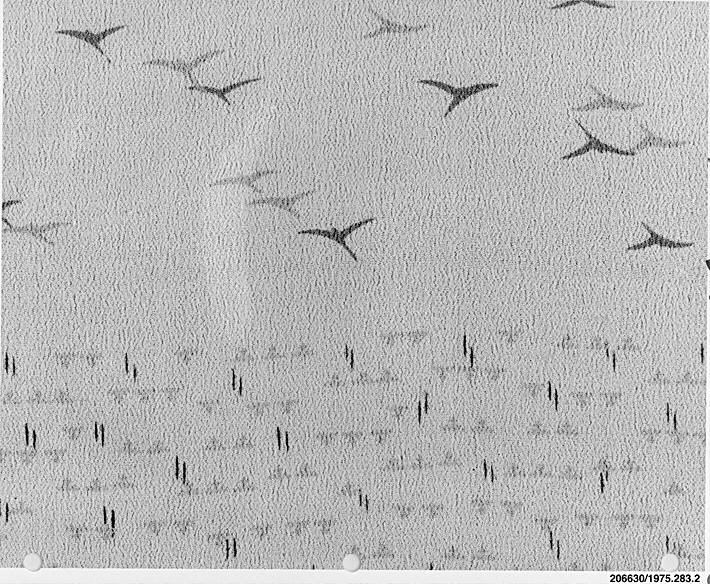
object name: obi sash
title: Sash for Use Under Obi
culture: japanese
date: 1801-1900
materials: silk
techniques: weave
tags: birds